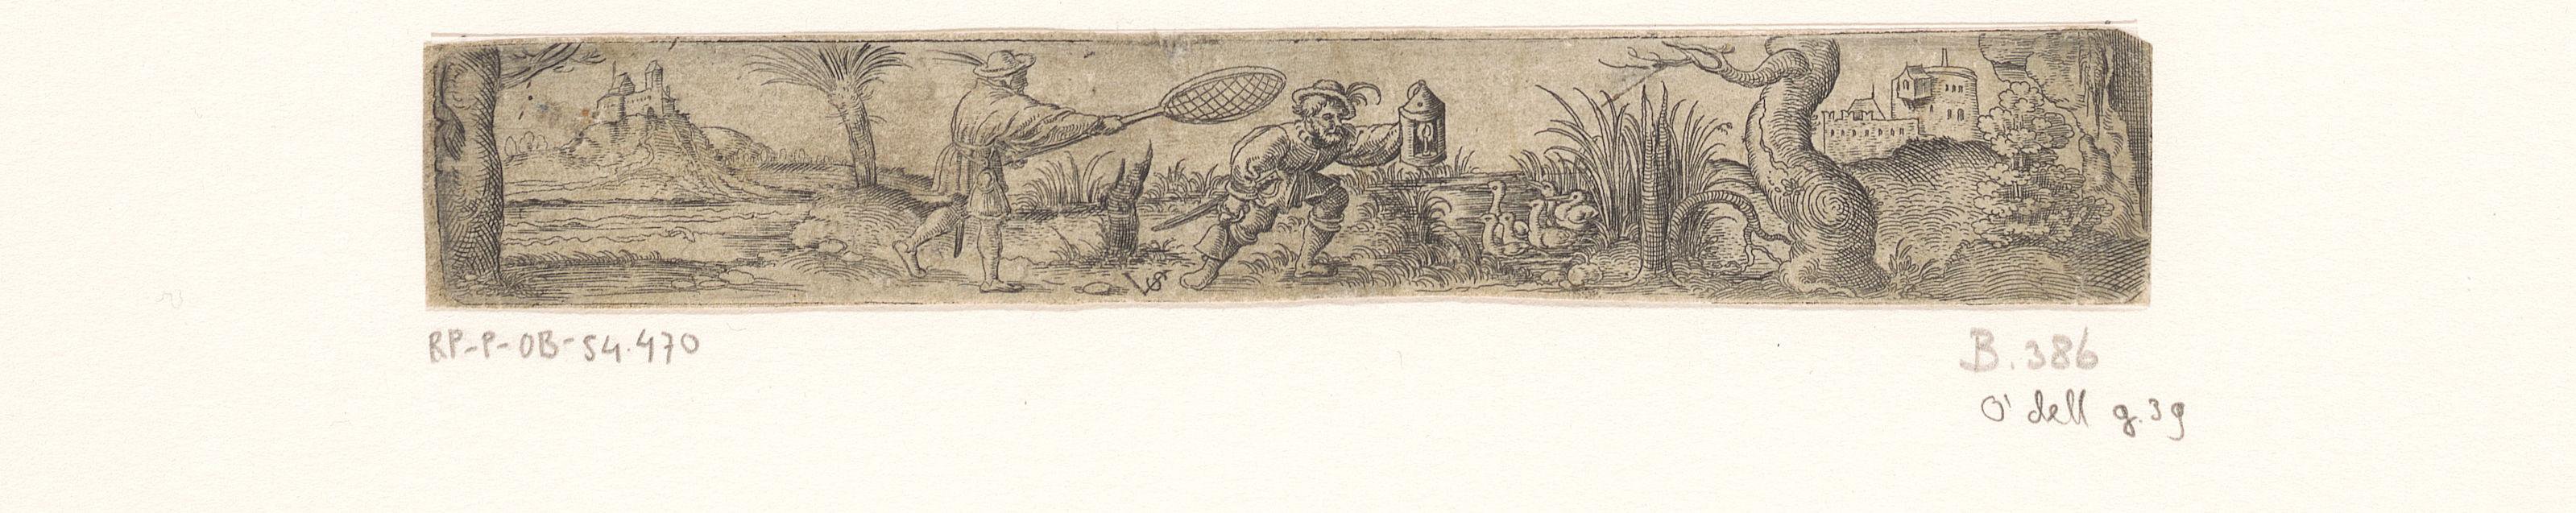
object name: print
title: Eendenjacht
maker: virgilius solis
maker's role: draughtsman, print maker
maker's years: 1514-1562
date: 1524-1562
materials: paper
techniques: engraving, etching, intaglio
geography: nuremberg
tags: city-view, and landscape with man-made constructions, bird hunting, lantern, water-birds: duck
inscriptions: collector's mark: Lugt 2228, number: ‘25’